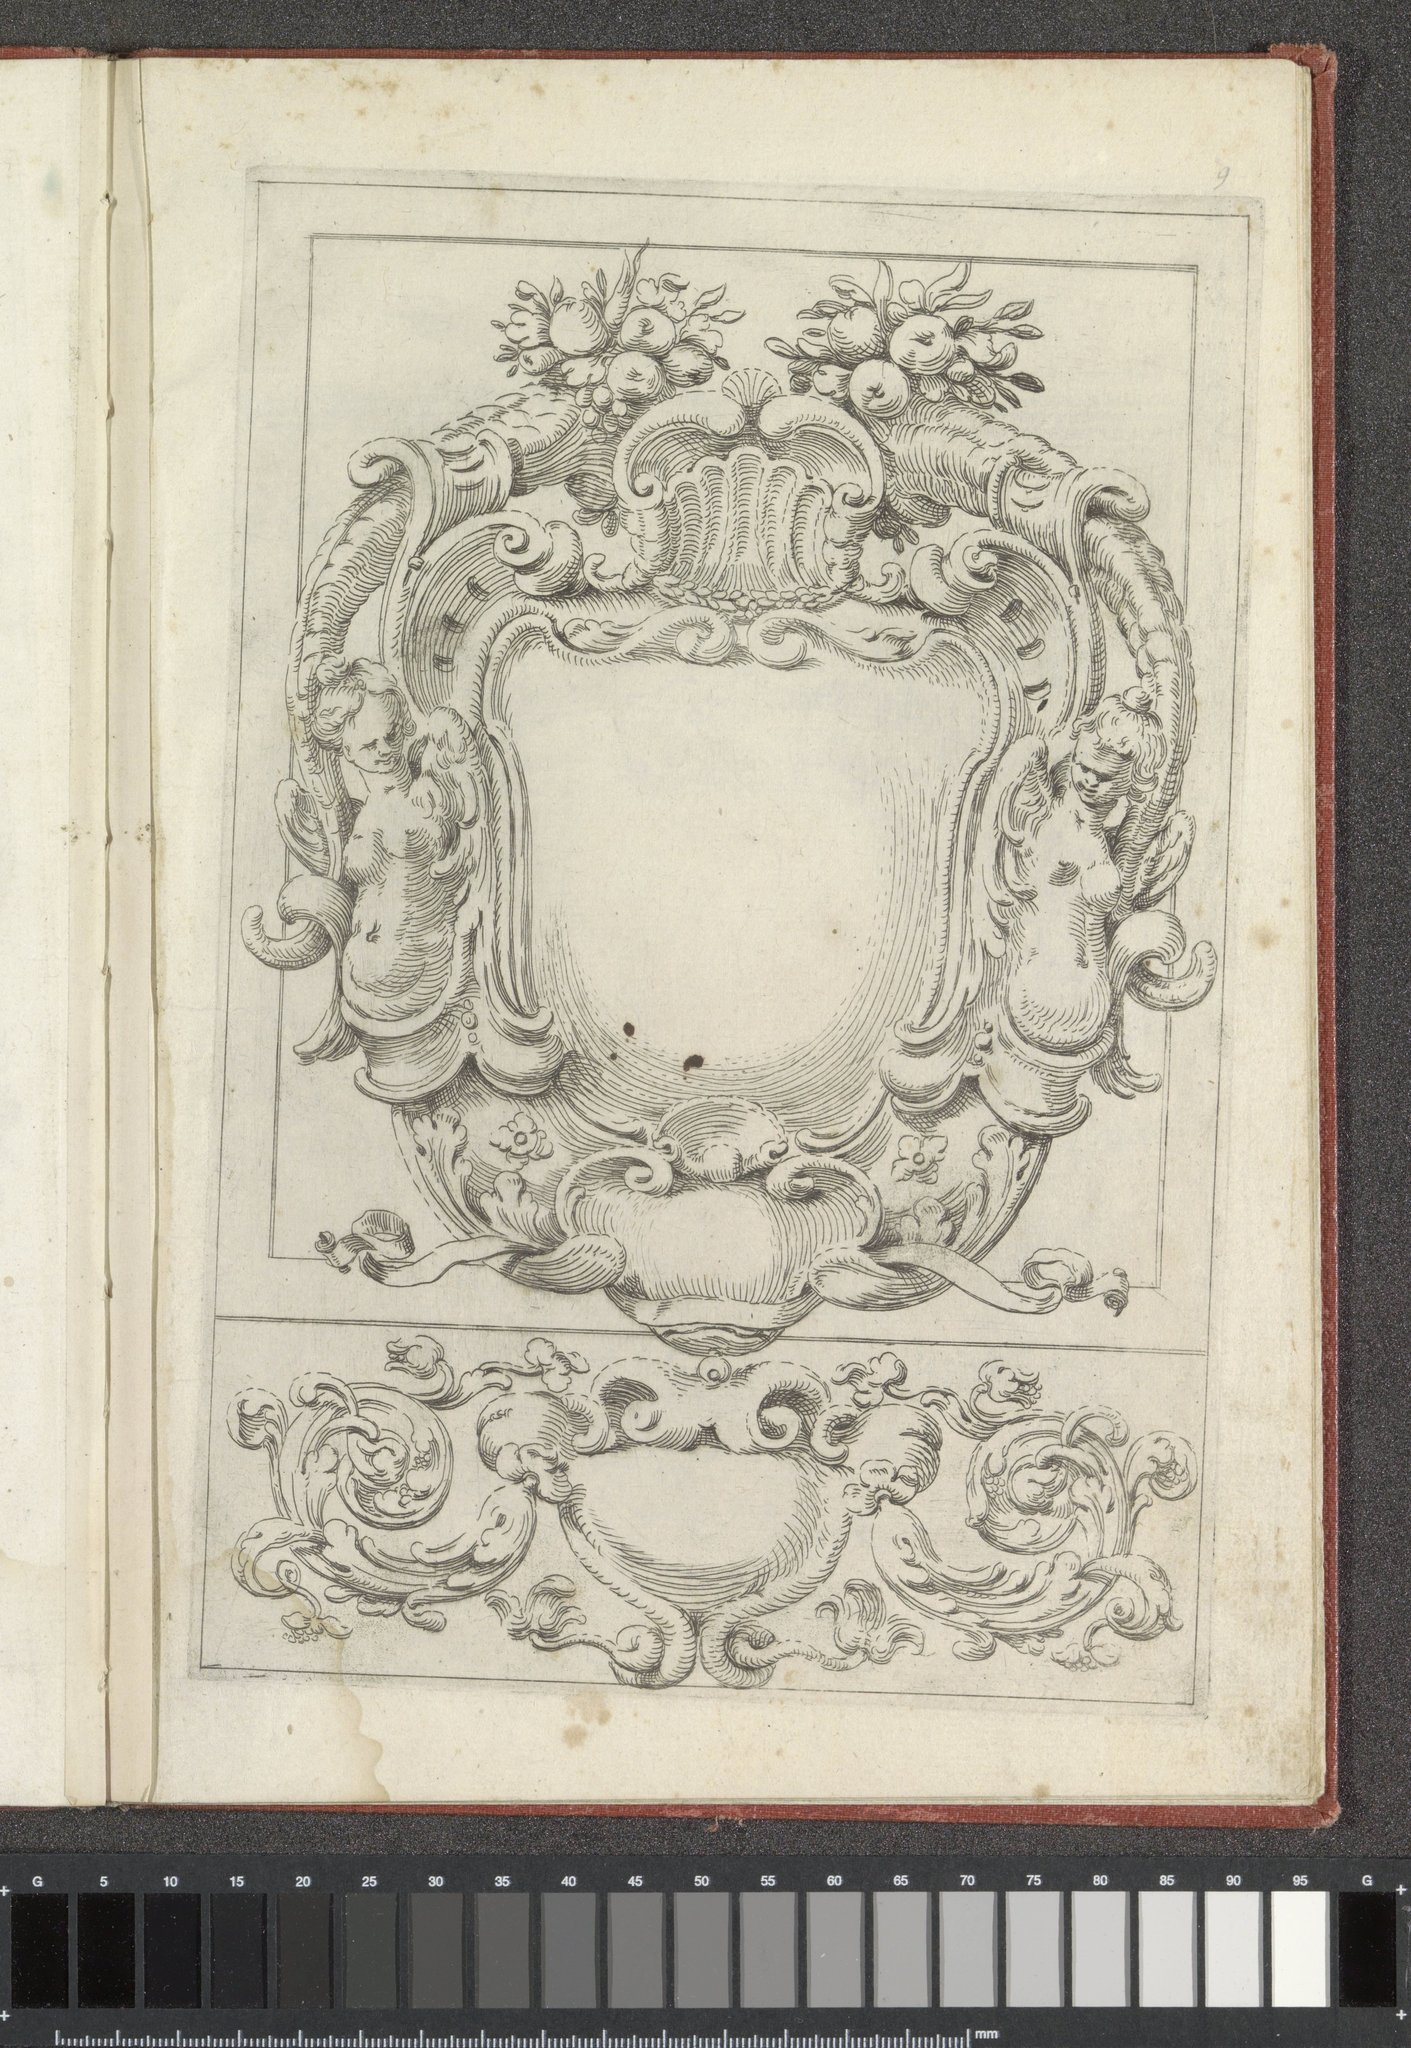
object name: print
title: Cartouches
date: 1636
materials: paper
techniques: etching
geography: bologna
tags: fabulous beings with wings - aa - female human figure, foliage ~ ornament, ornament ~ cartouche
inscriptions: collector's mark: Lugt 2760, collector's mark: Lugt 2228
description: Boven een cartouche met in de rand gevleugelde vrouwenfiguren die overlopen in ornament. Onder een cartouche aan weerszijden geflankeerd door krullen. De prent maakt deel uit van een album.